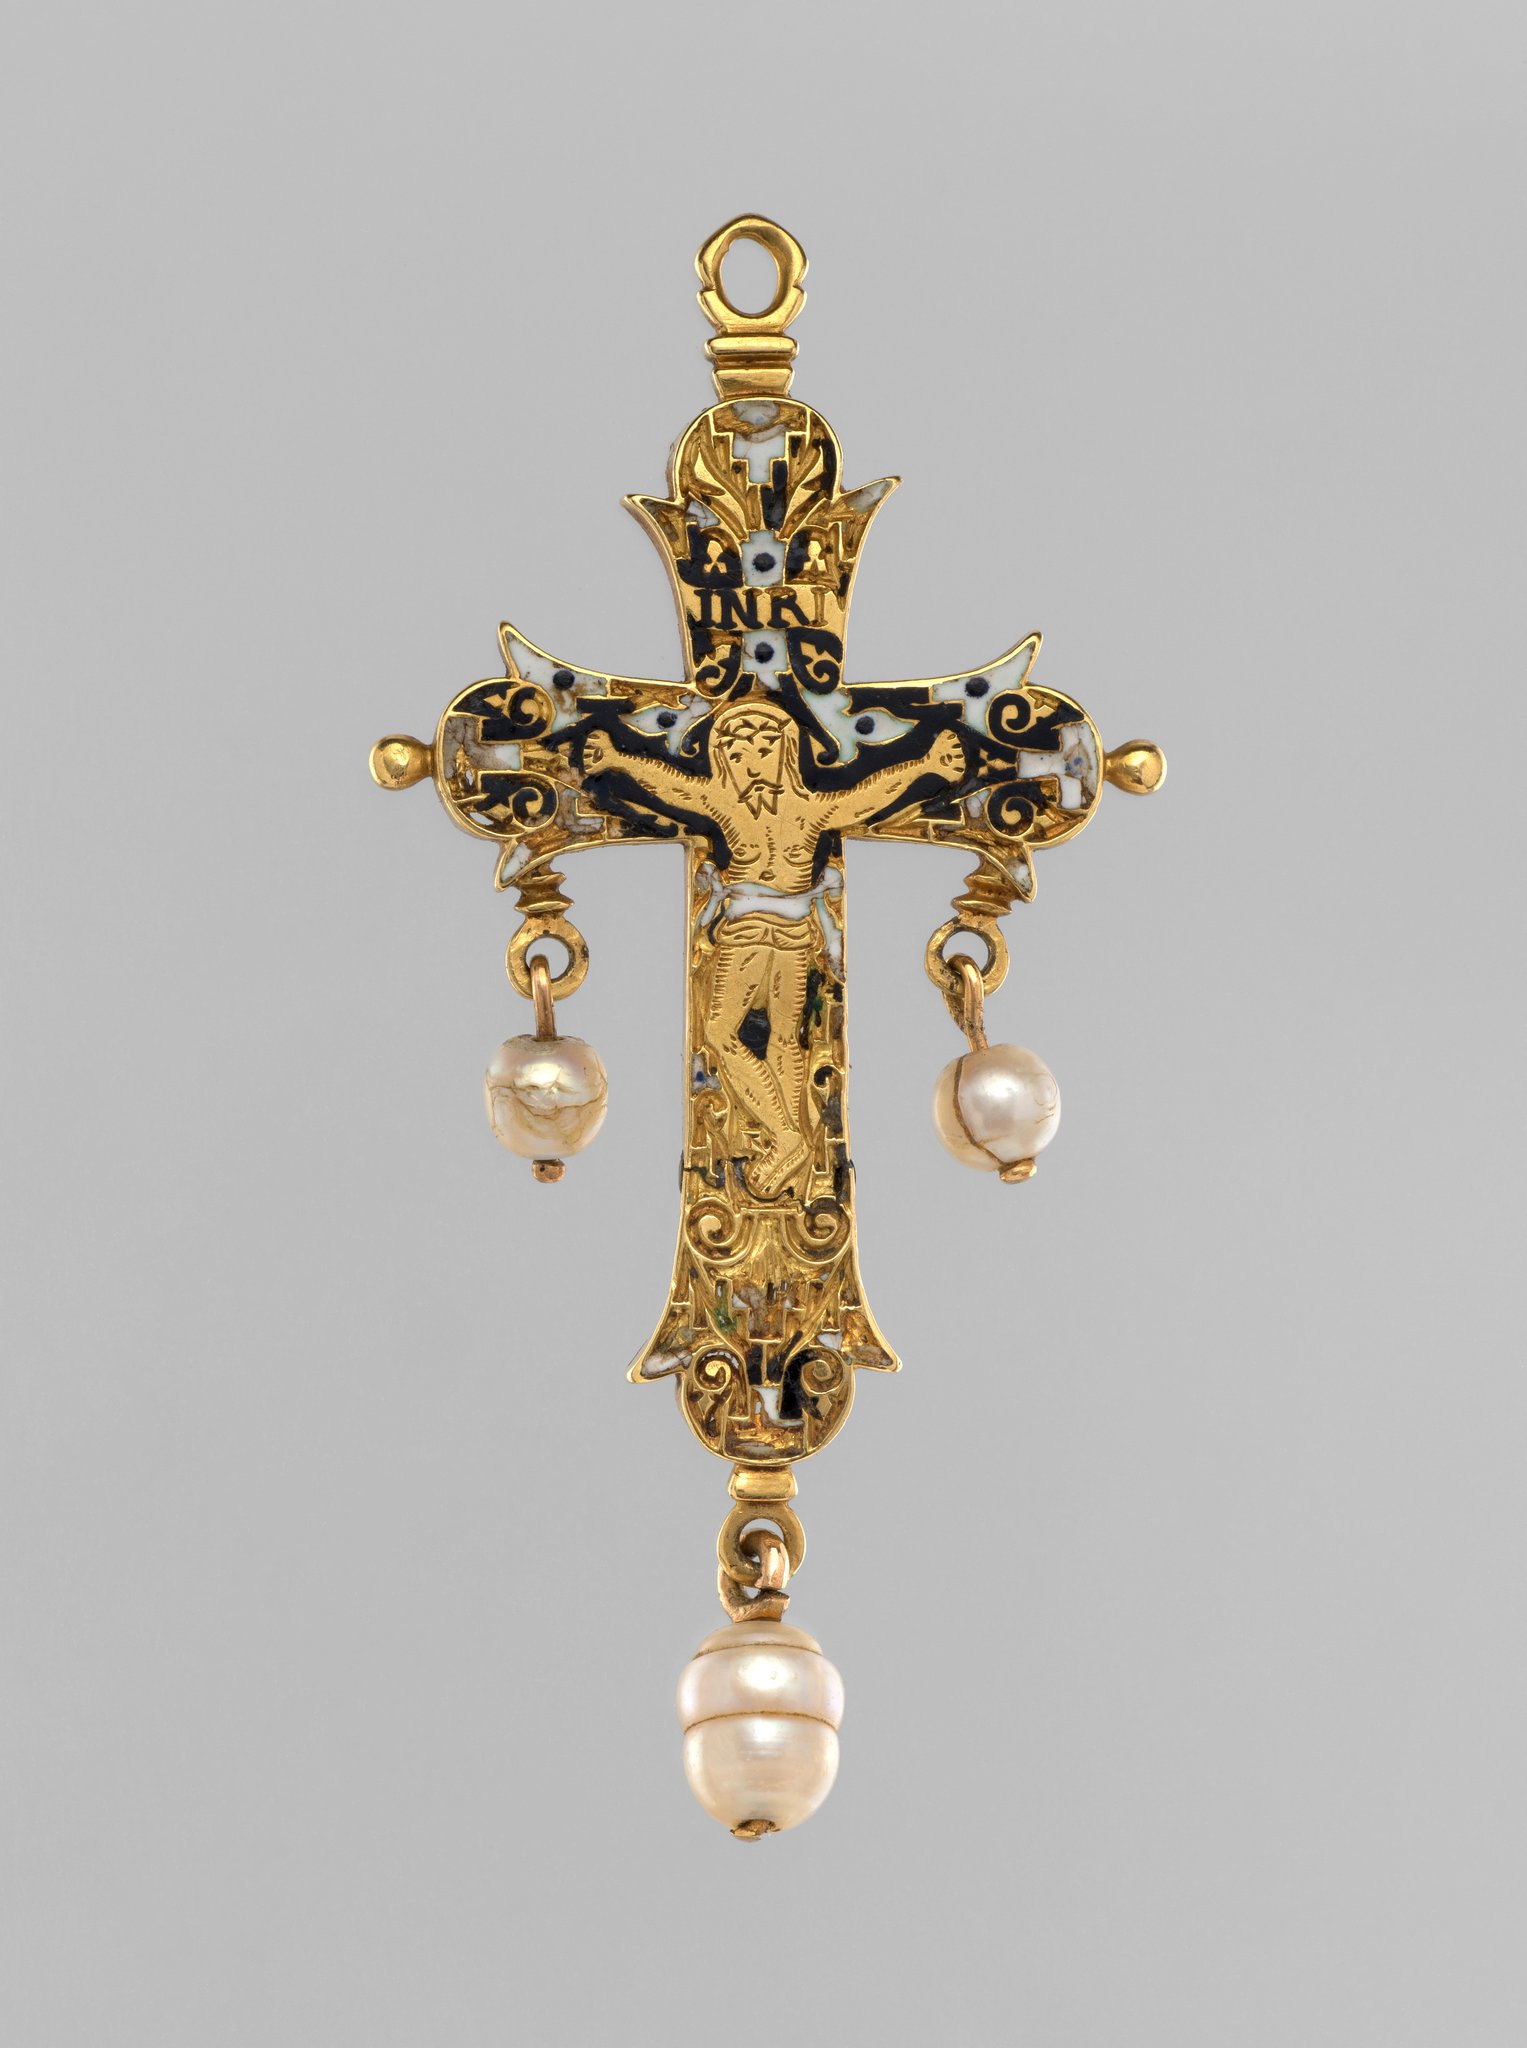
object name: pendant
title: Reliquary crucifix pendant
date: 1601-1800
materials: enamel, gold, hair, pearl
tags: jesus,crucifixion